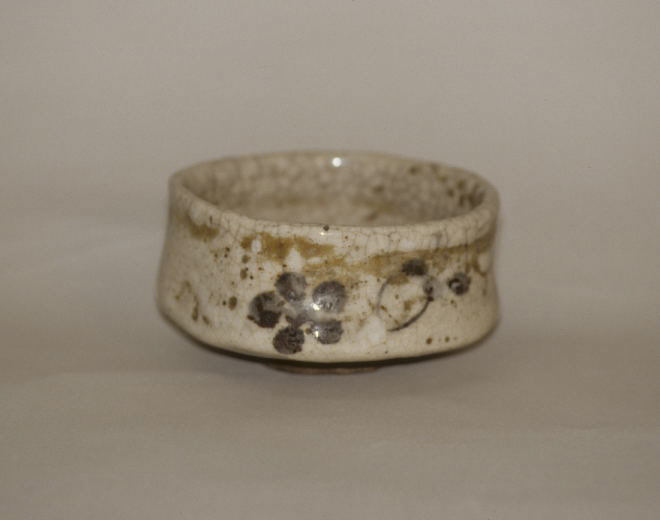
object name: teabowl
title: Tea bowl decorated with chrysanthemums and wavy lines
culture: japanese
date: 1700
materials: clay, glaze